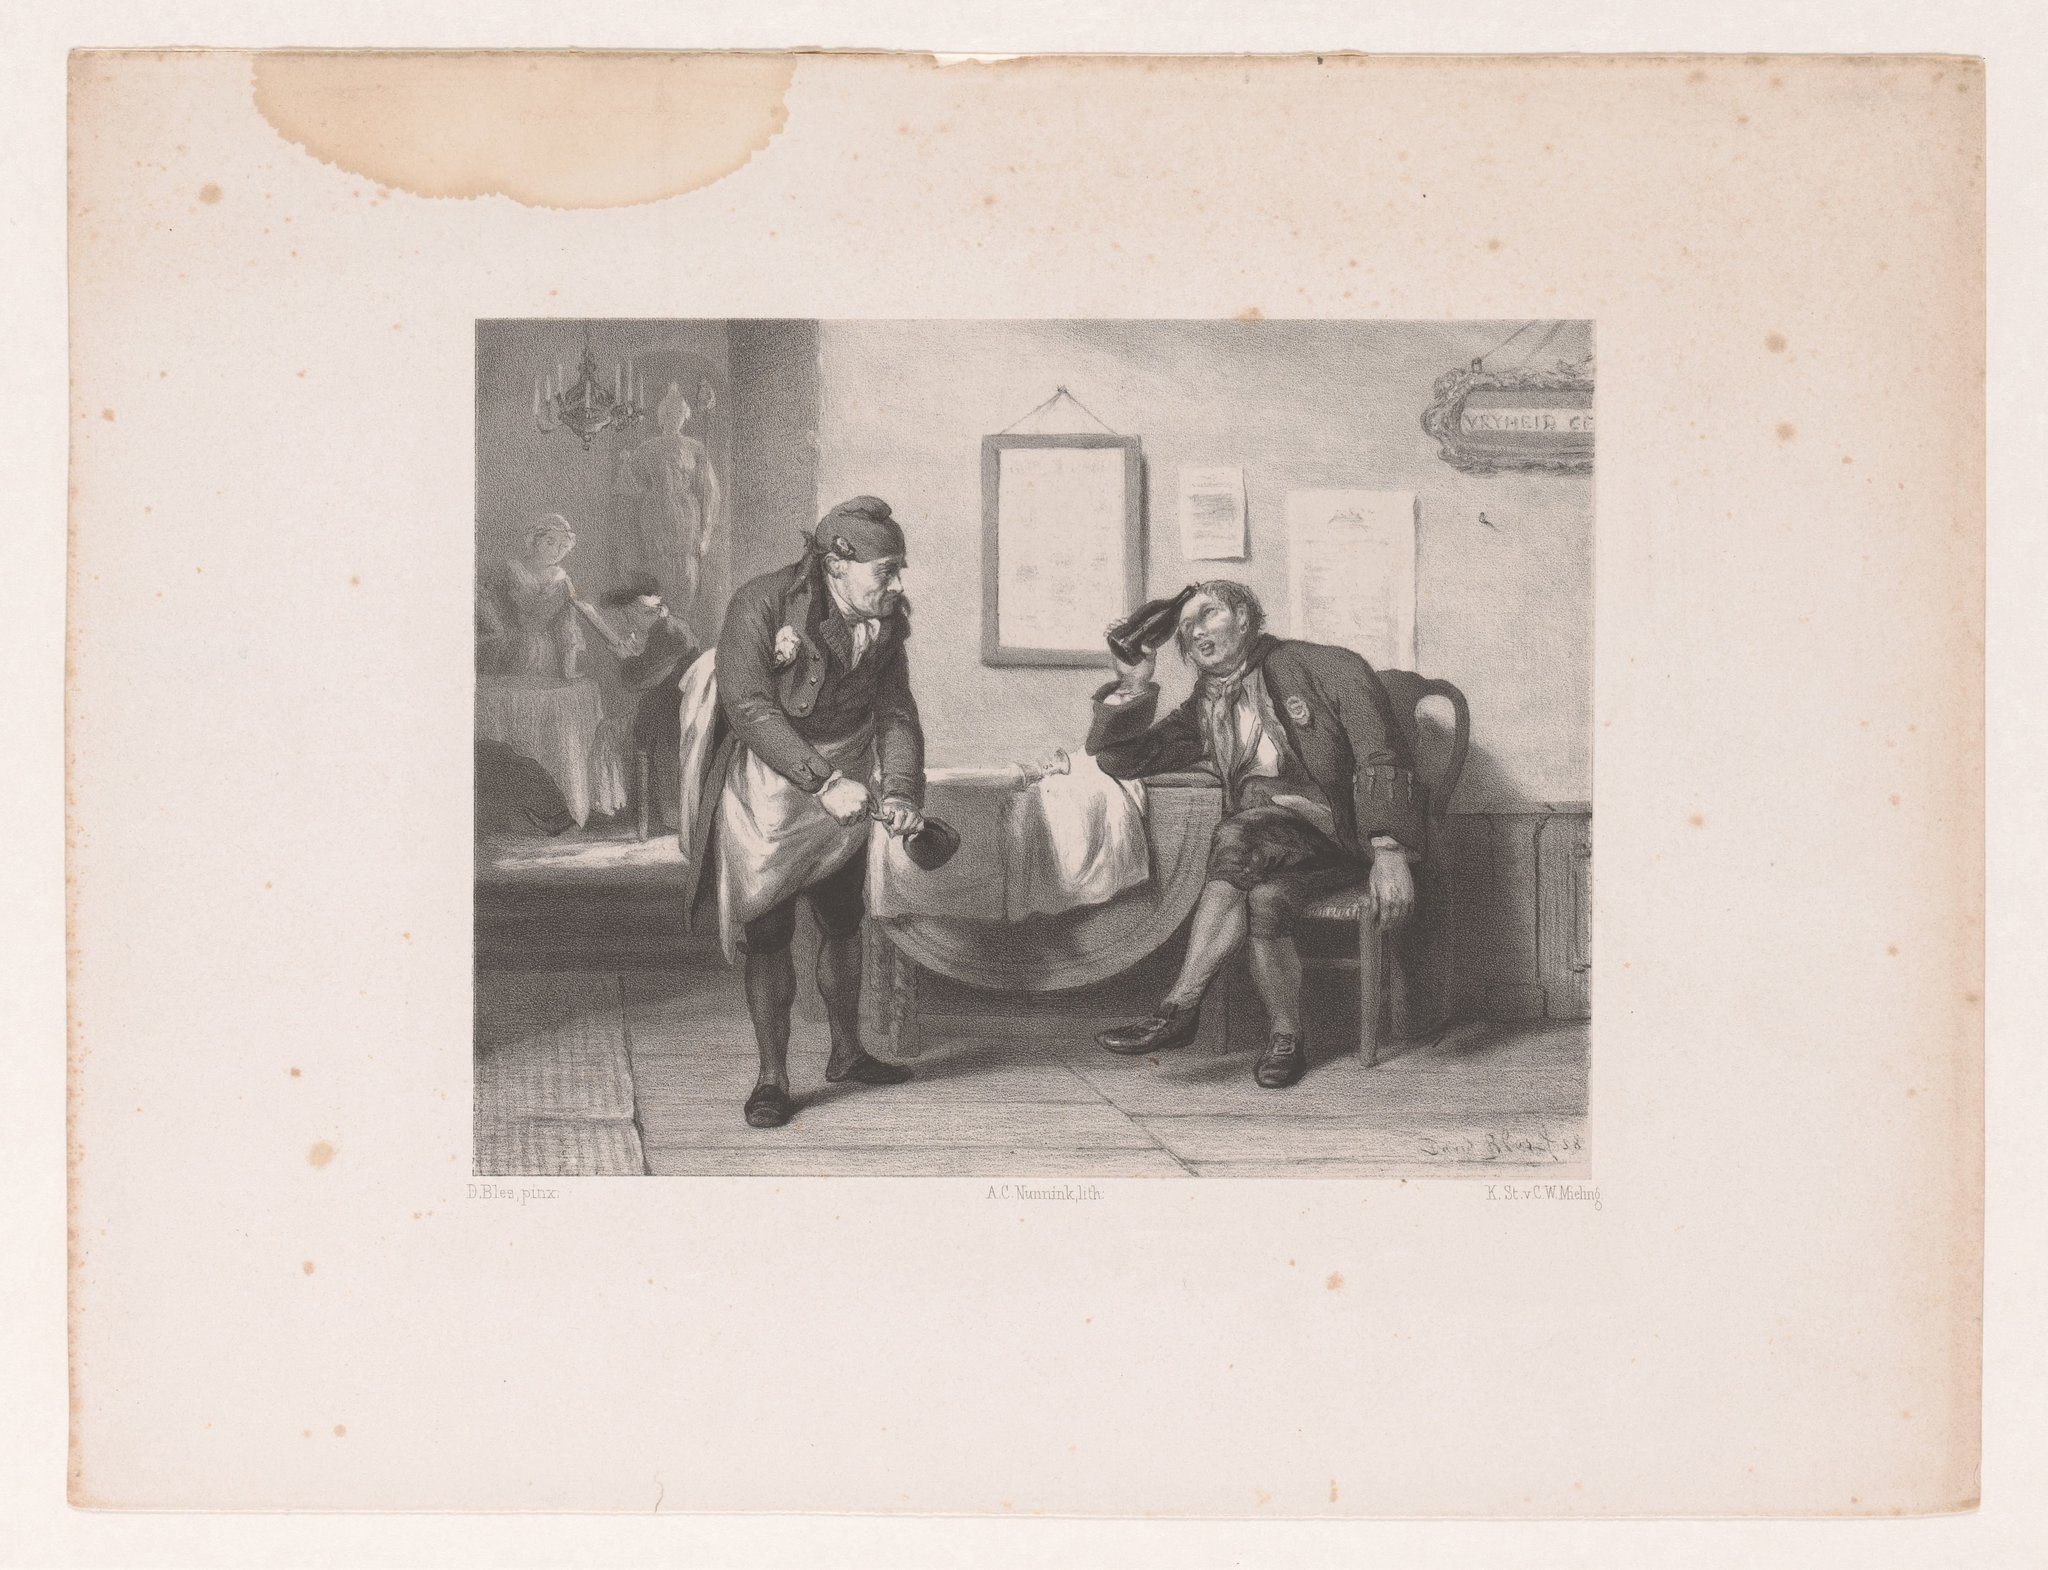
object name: print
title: Twee drinkende knechten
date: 1858-1865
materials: paper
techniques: lithograph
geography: the hague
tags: drinking, house personnel, servants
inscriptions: collector's mark: Lugt 2228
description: Twee knechten drinken hun meesters wijn. Links een doorkijk richting een dienstmeid en een man aan tafel.